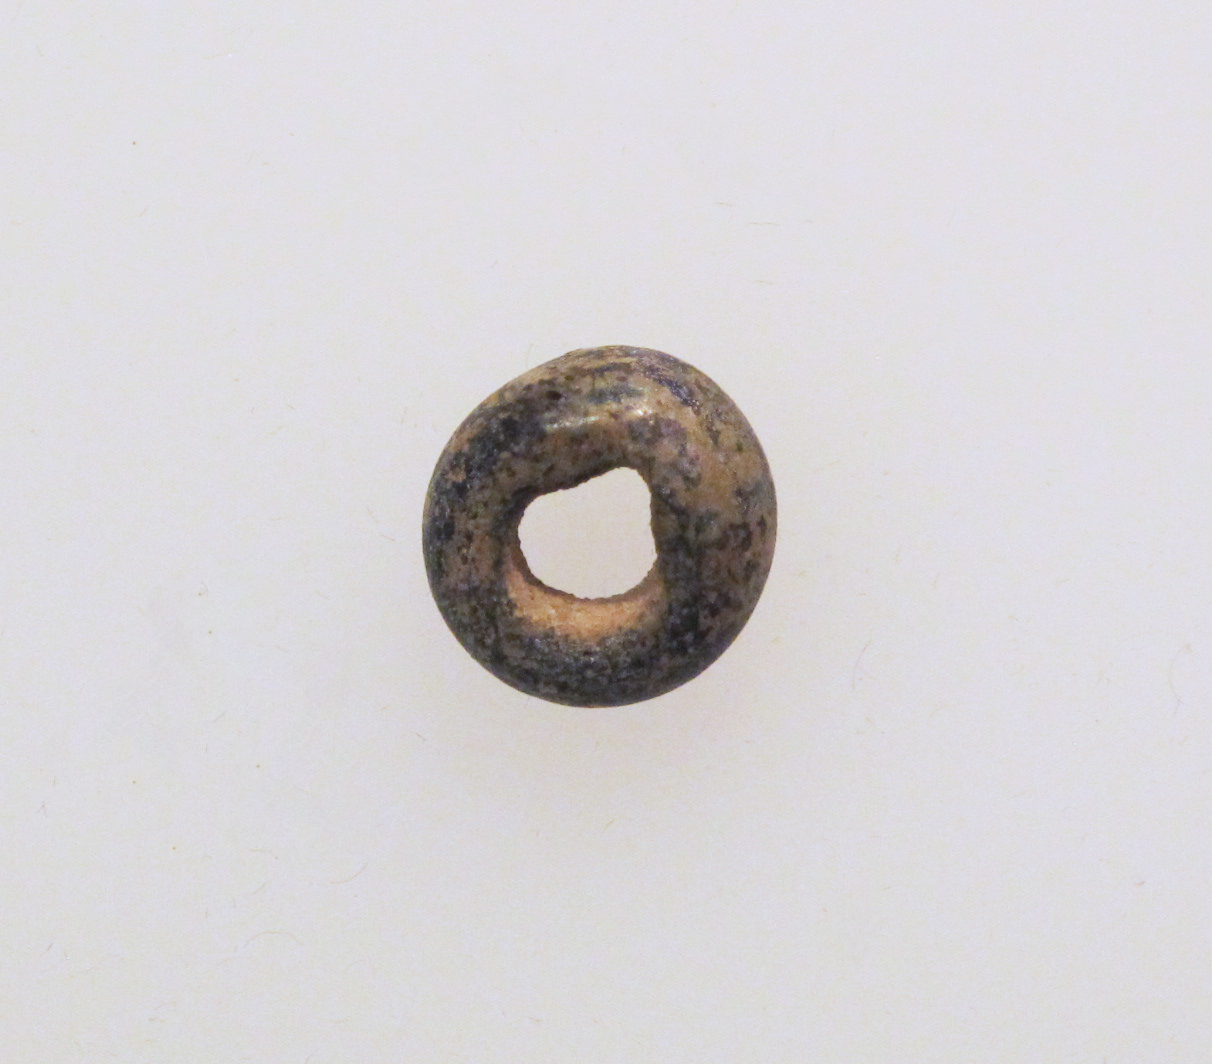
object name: bead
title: Glass bead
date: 7000 BCE-330 CE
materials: glass